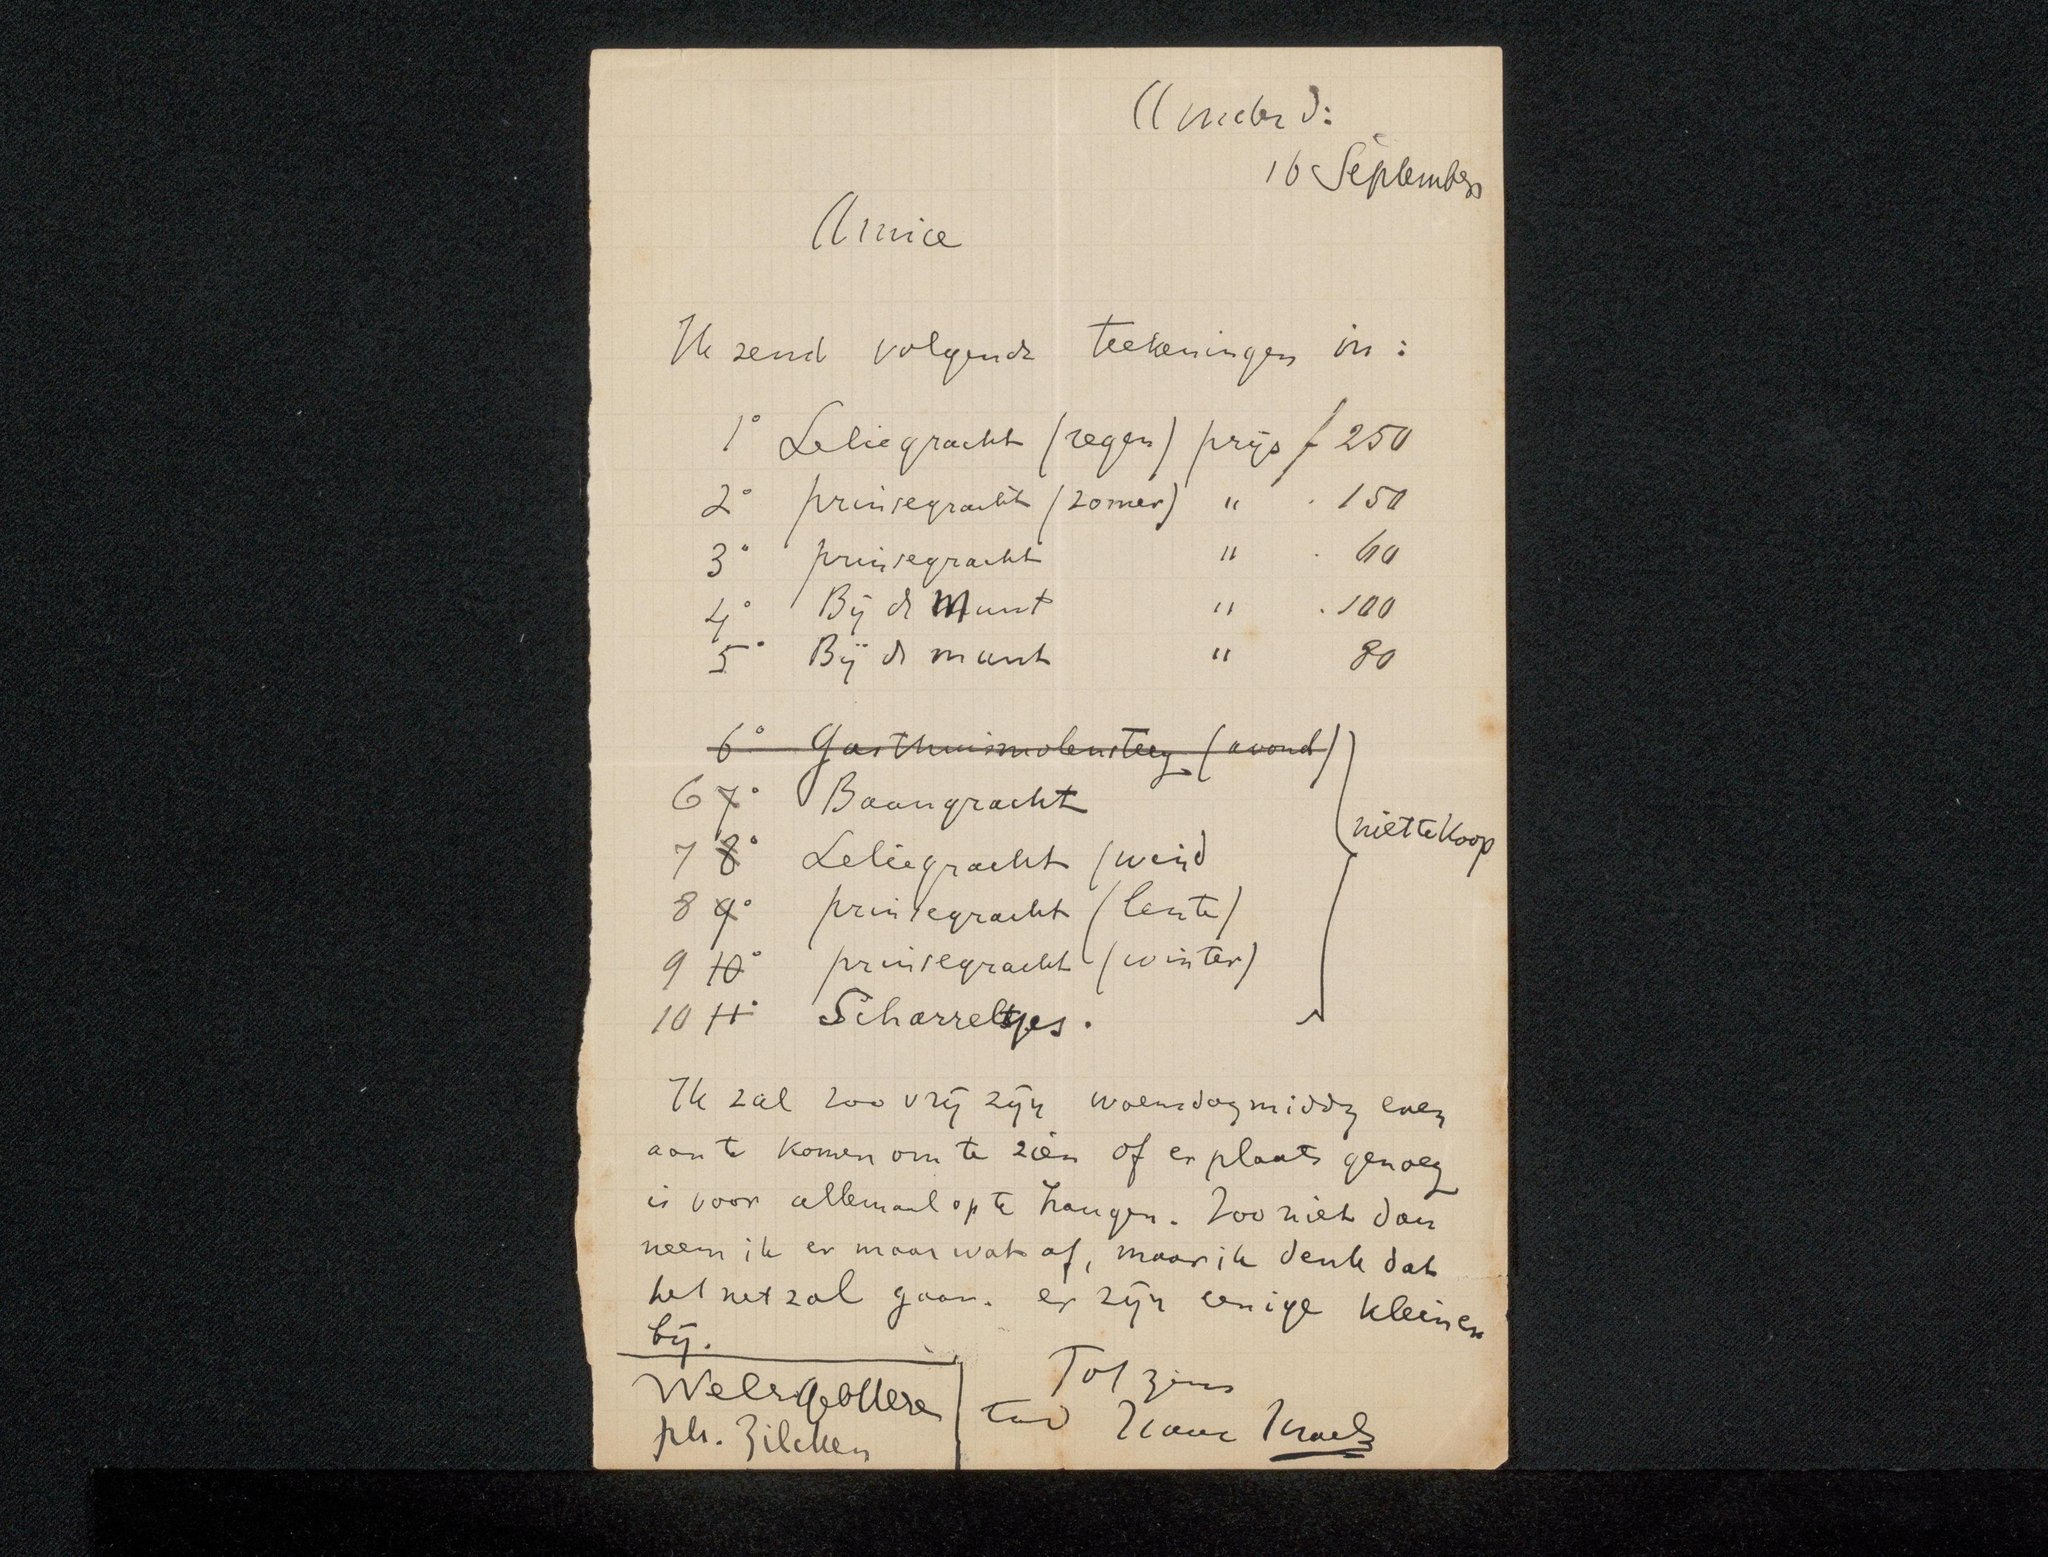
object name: letter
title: Brief aan Philip Zilcken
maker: isaac israels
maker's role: draughtsman, painter, print maker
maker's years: 1865-1934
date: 1875-1930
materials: ink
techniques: writing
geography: amsterdam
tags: philip zilcken, drawing, money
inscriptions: collector's mark: ‘RPK’